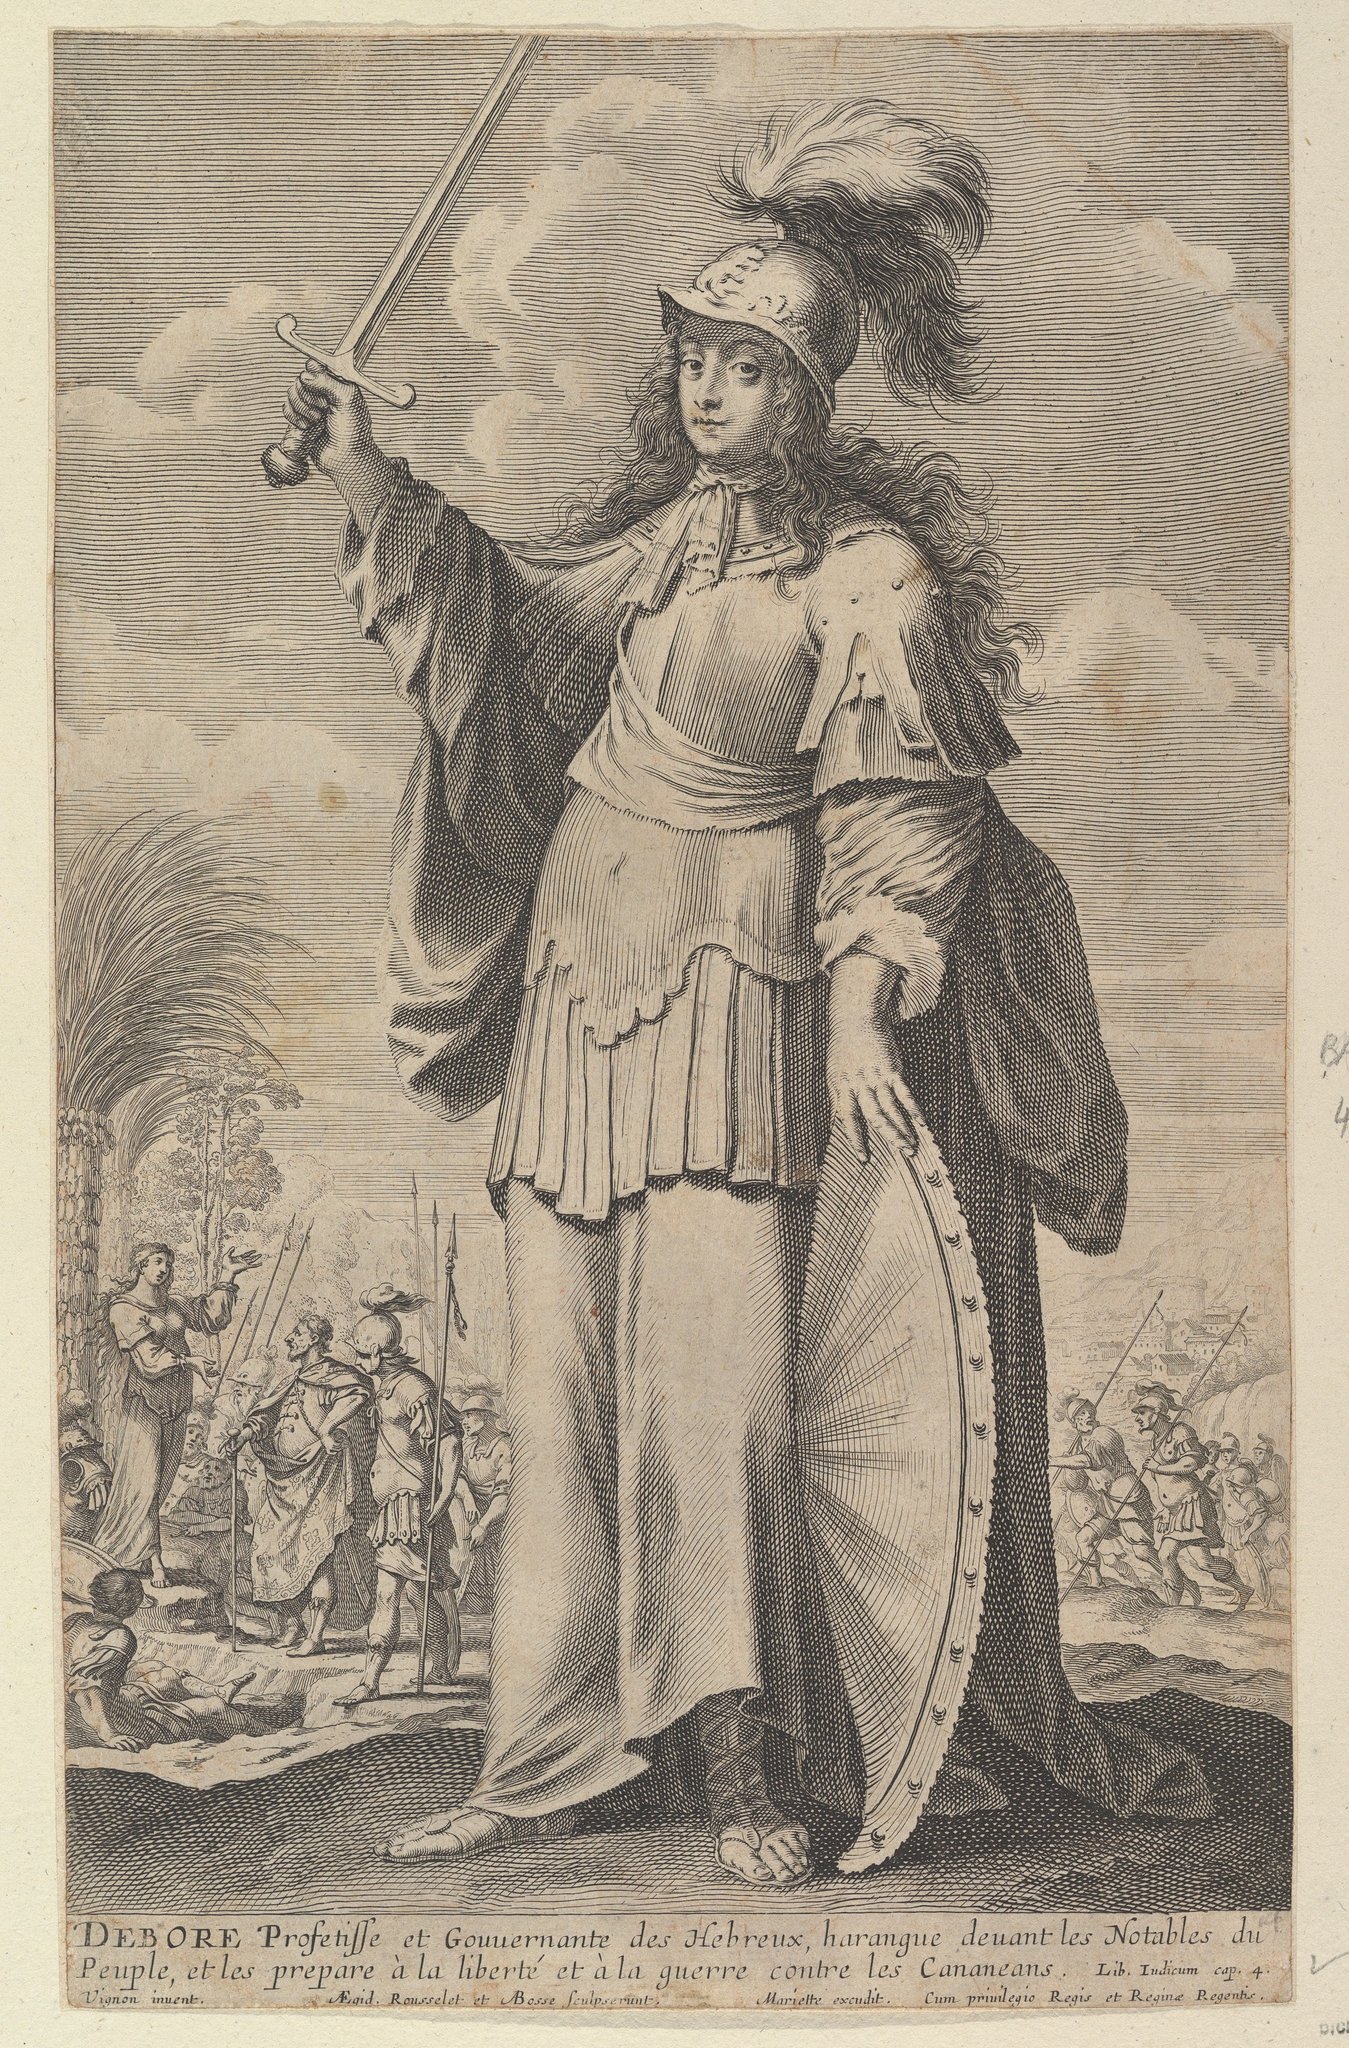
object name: print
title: Déborah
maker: gilles rousselet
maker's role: artist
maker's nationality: french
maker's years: 1614-1686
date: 1647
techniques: engraving, etching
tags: helmets,shields,swords,women